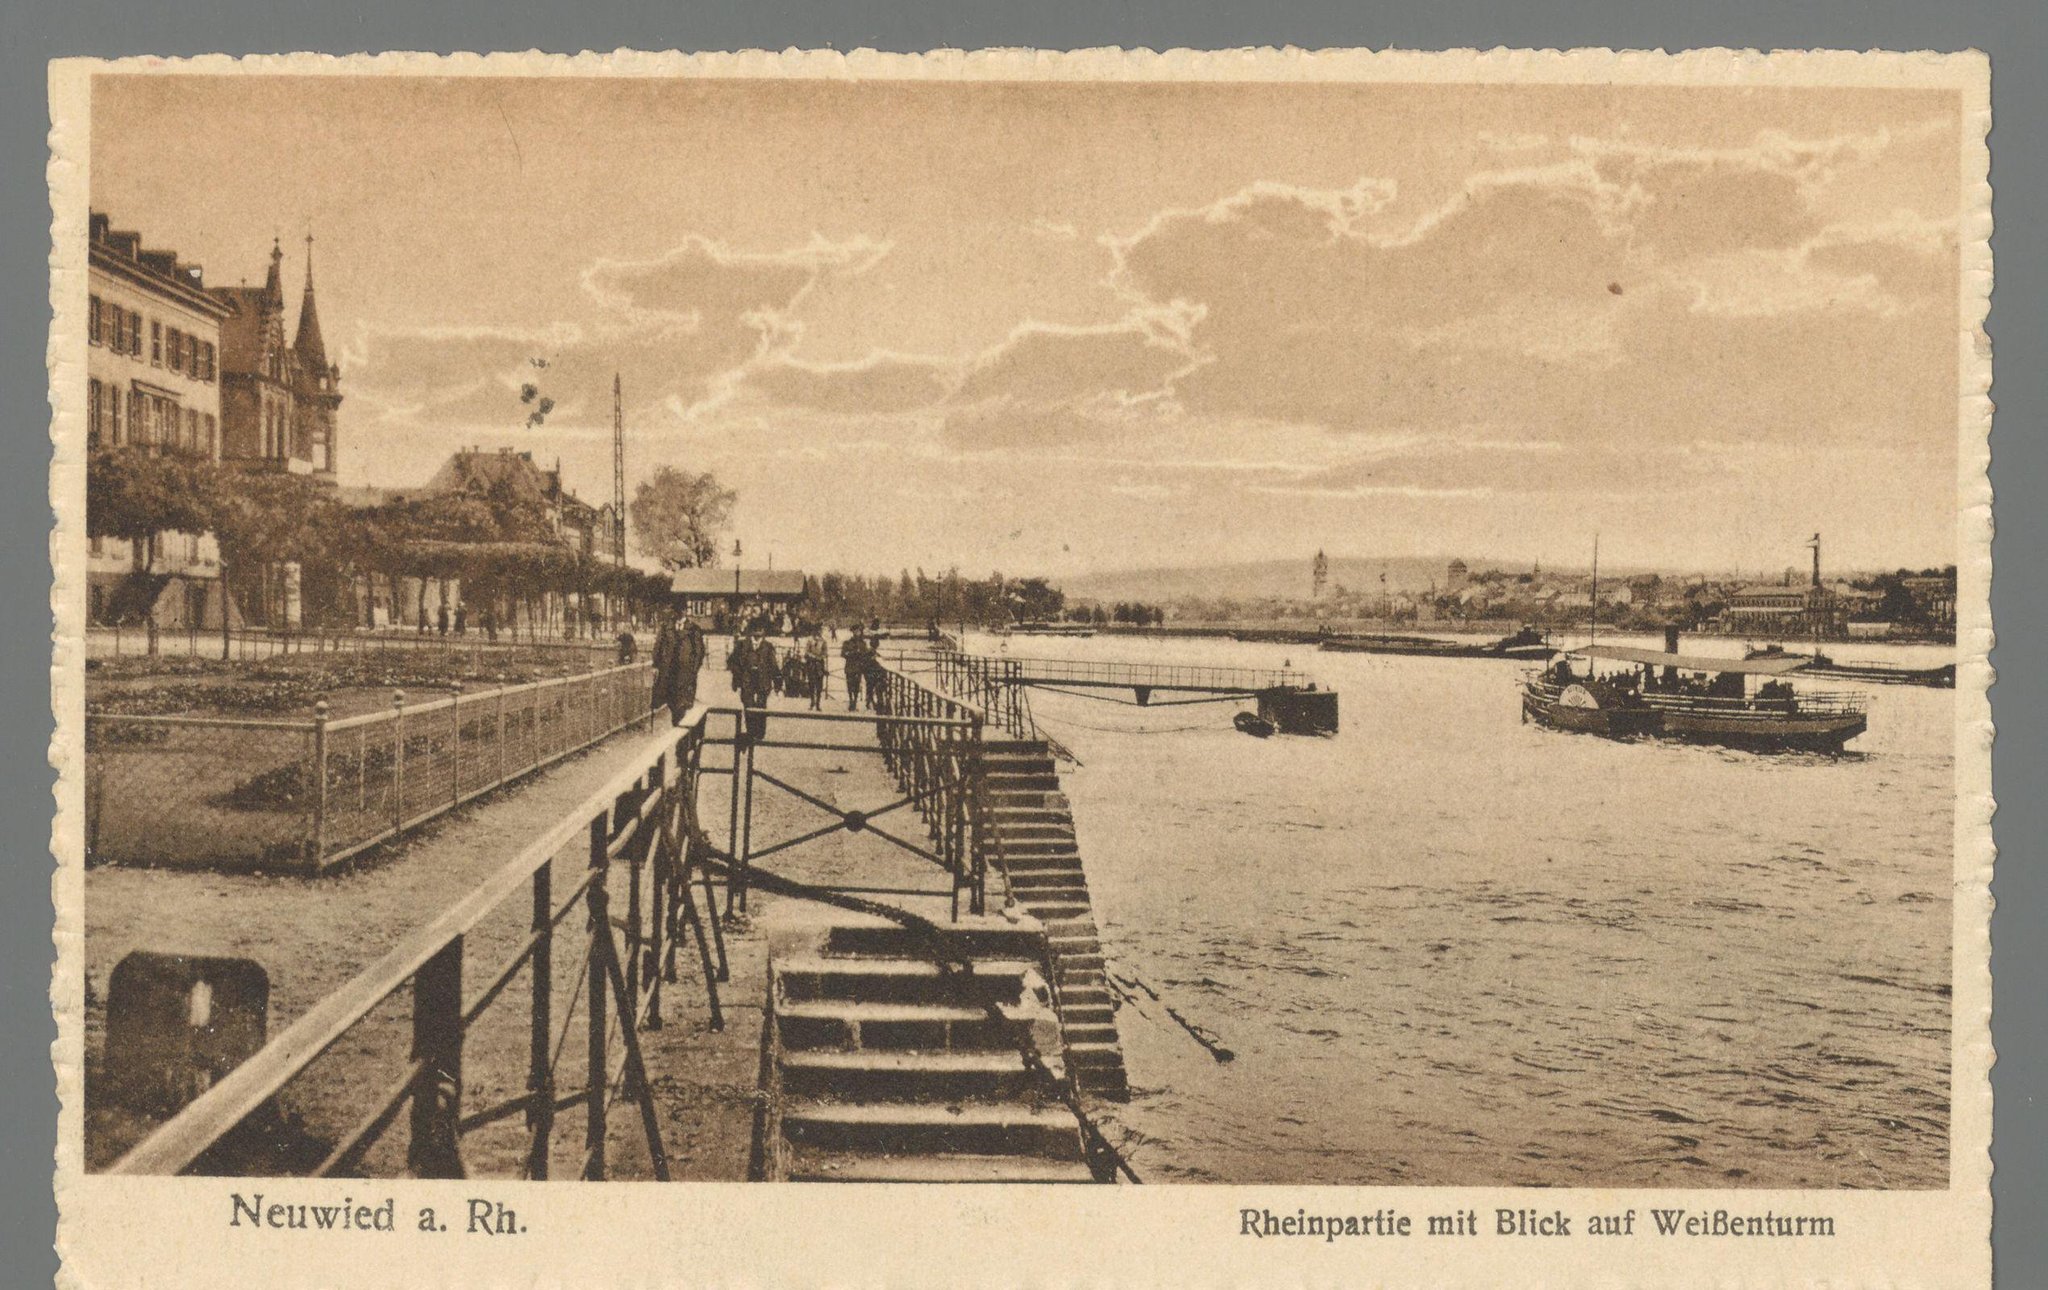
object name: photomechanical print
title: Neuwied a. Rh. Rheinpartie mit Blick auf Weiβenturm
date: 1905-1925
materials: cardboard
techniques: photograph, writing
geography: neuwied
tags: city-view, and landscape with man-made constructions, canals, waters (in city)